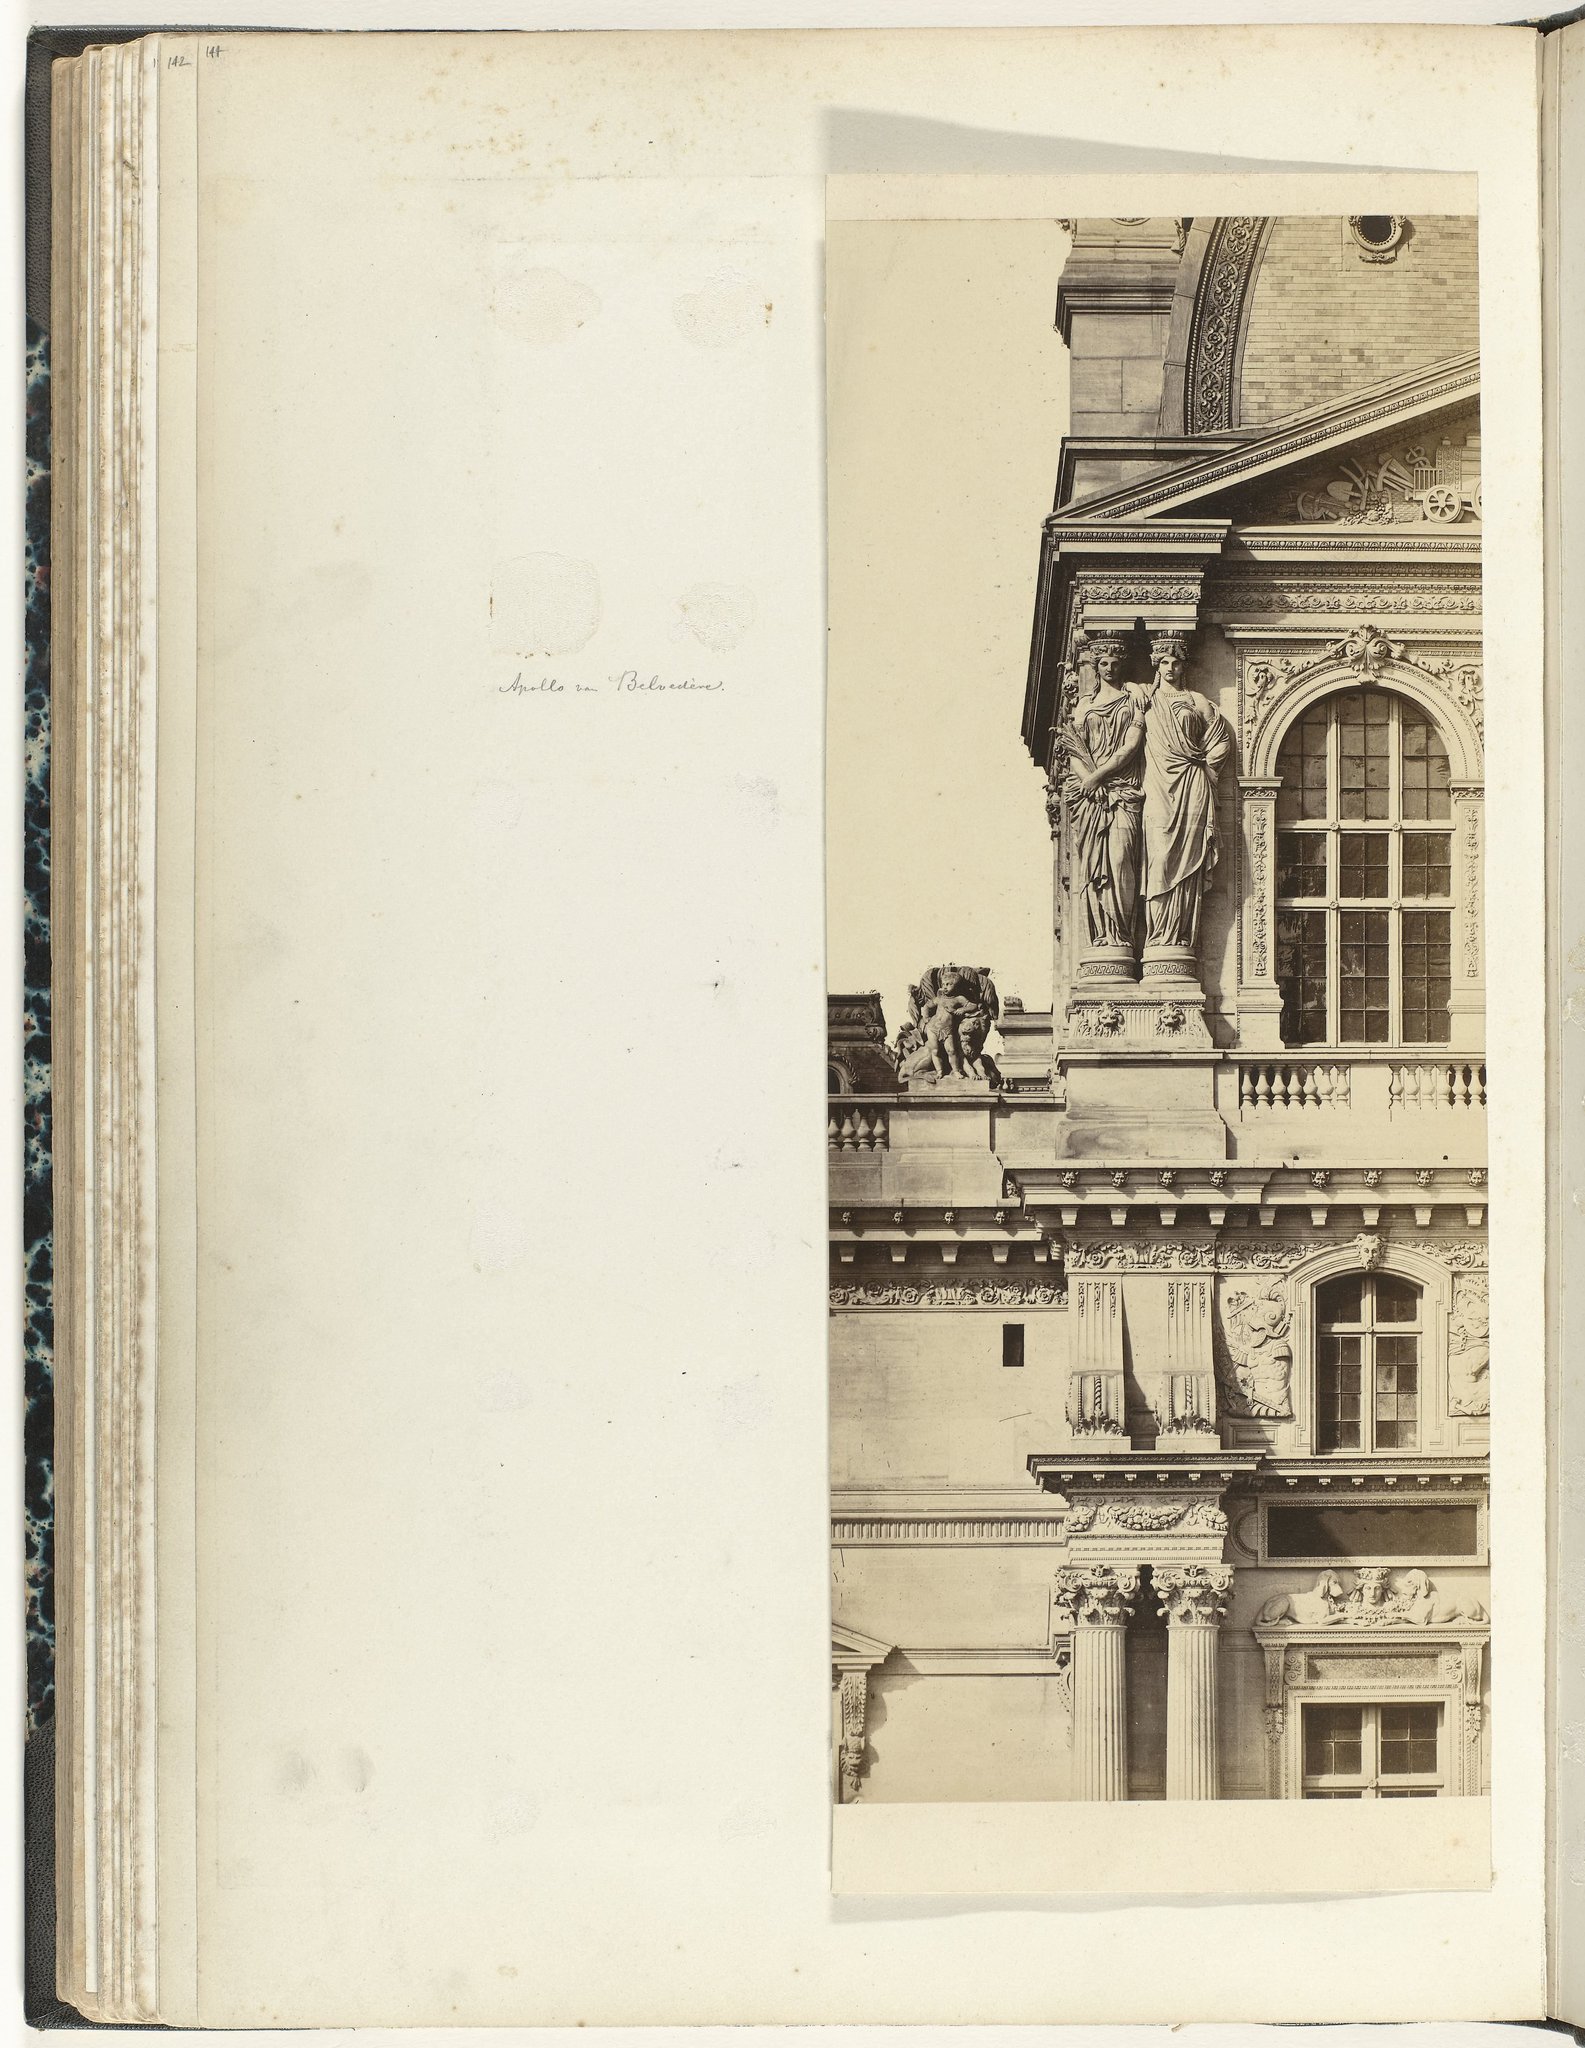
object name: photograph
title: Detail van paviljoen Richelieu van het Louvre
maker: édouard denis baldus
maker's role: fotograaf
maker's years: 1813-1889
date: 1856-1857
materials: cardboard, paper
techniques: salted paper print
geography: paris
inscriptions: annotation: ‘Apollo van Belvedère.’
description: Onder het hoofdgestel staan twee vrouwelijke kariatiden, links van hen leunt een putto op een leeuw.